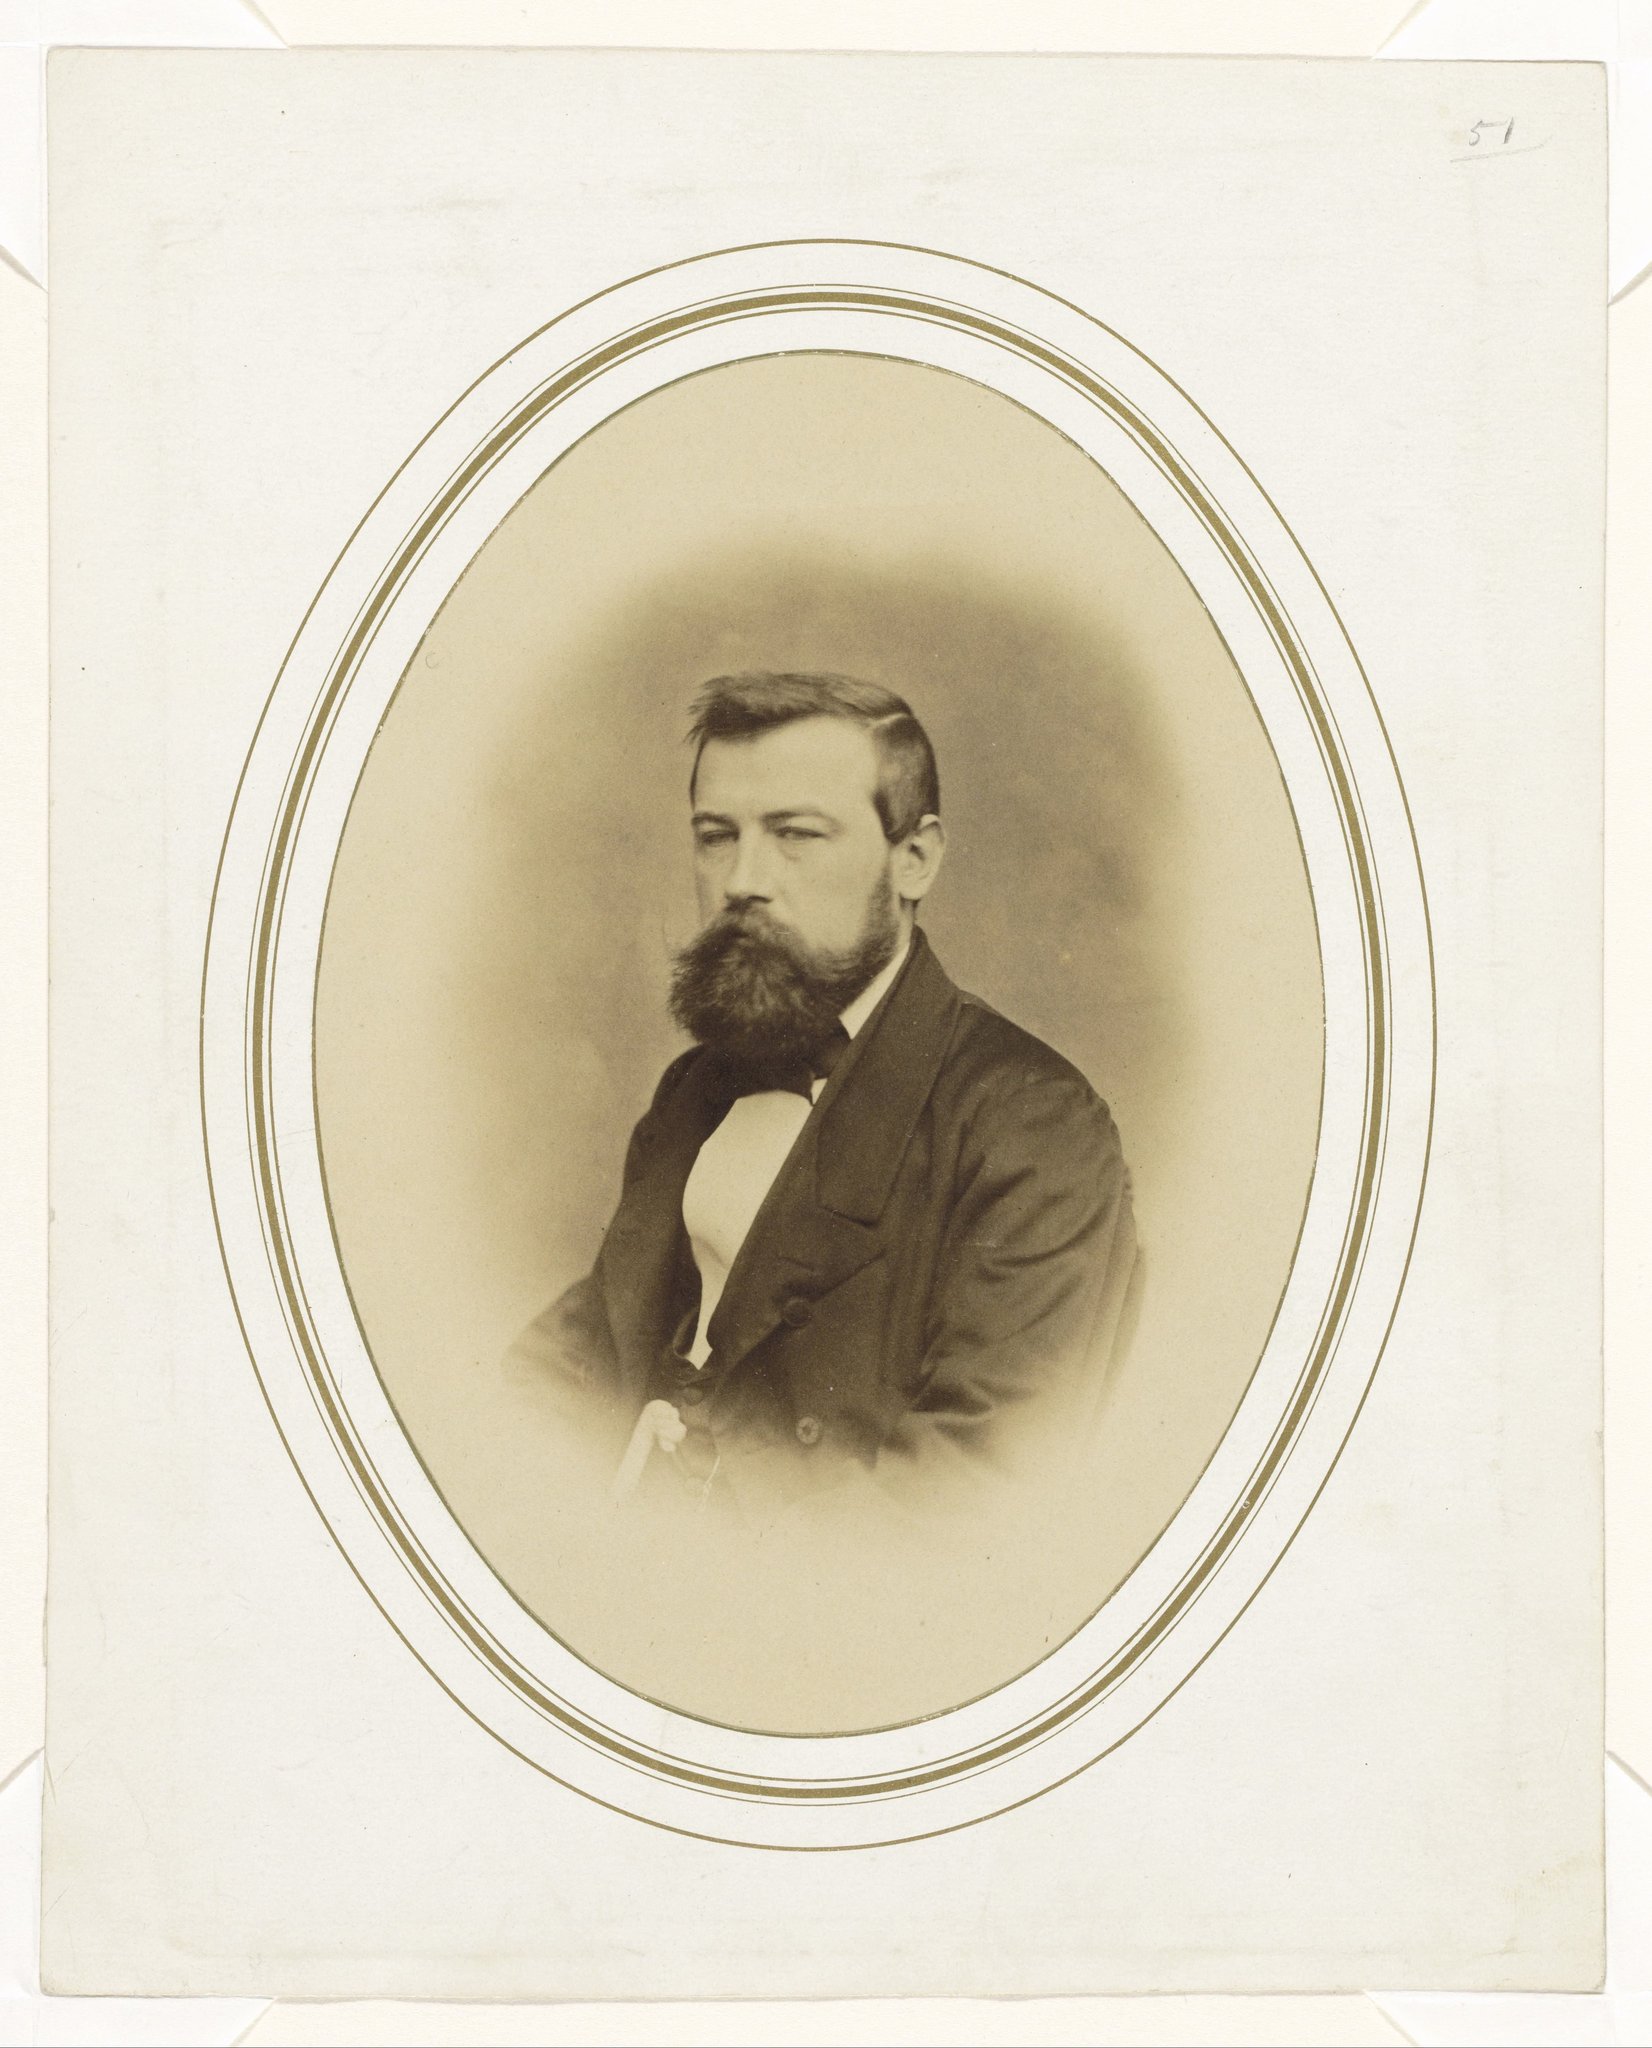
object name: photograph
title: Portret van een onbekende man met snor en baard, aangeduid als F. Chur, vrijmetselaar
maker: Anonymous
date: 1865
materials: cardboard, paper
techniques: albumen print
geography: germany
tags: adult man, historical persons, cleves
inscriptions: number: ‘51’, inscription: ‘F. Chur/ [...]/ 1865’, inscription: ‘Redenaar der Loge Zur Hoffnung/ te/ Kleve/ Dit portret behoort bij die in het/ phot. album waarmede ik het (zie/ teekenpl. dier [...]) gelijktijdig ontving.’